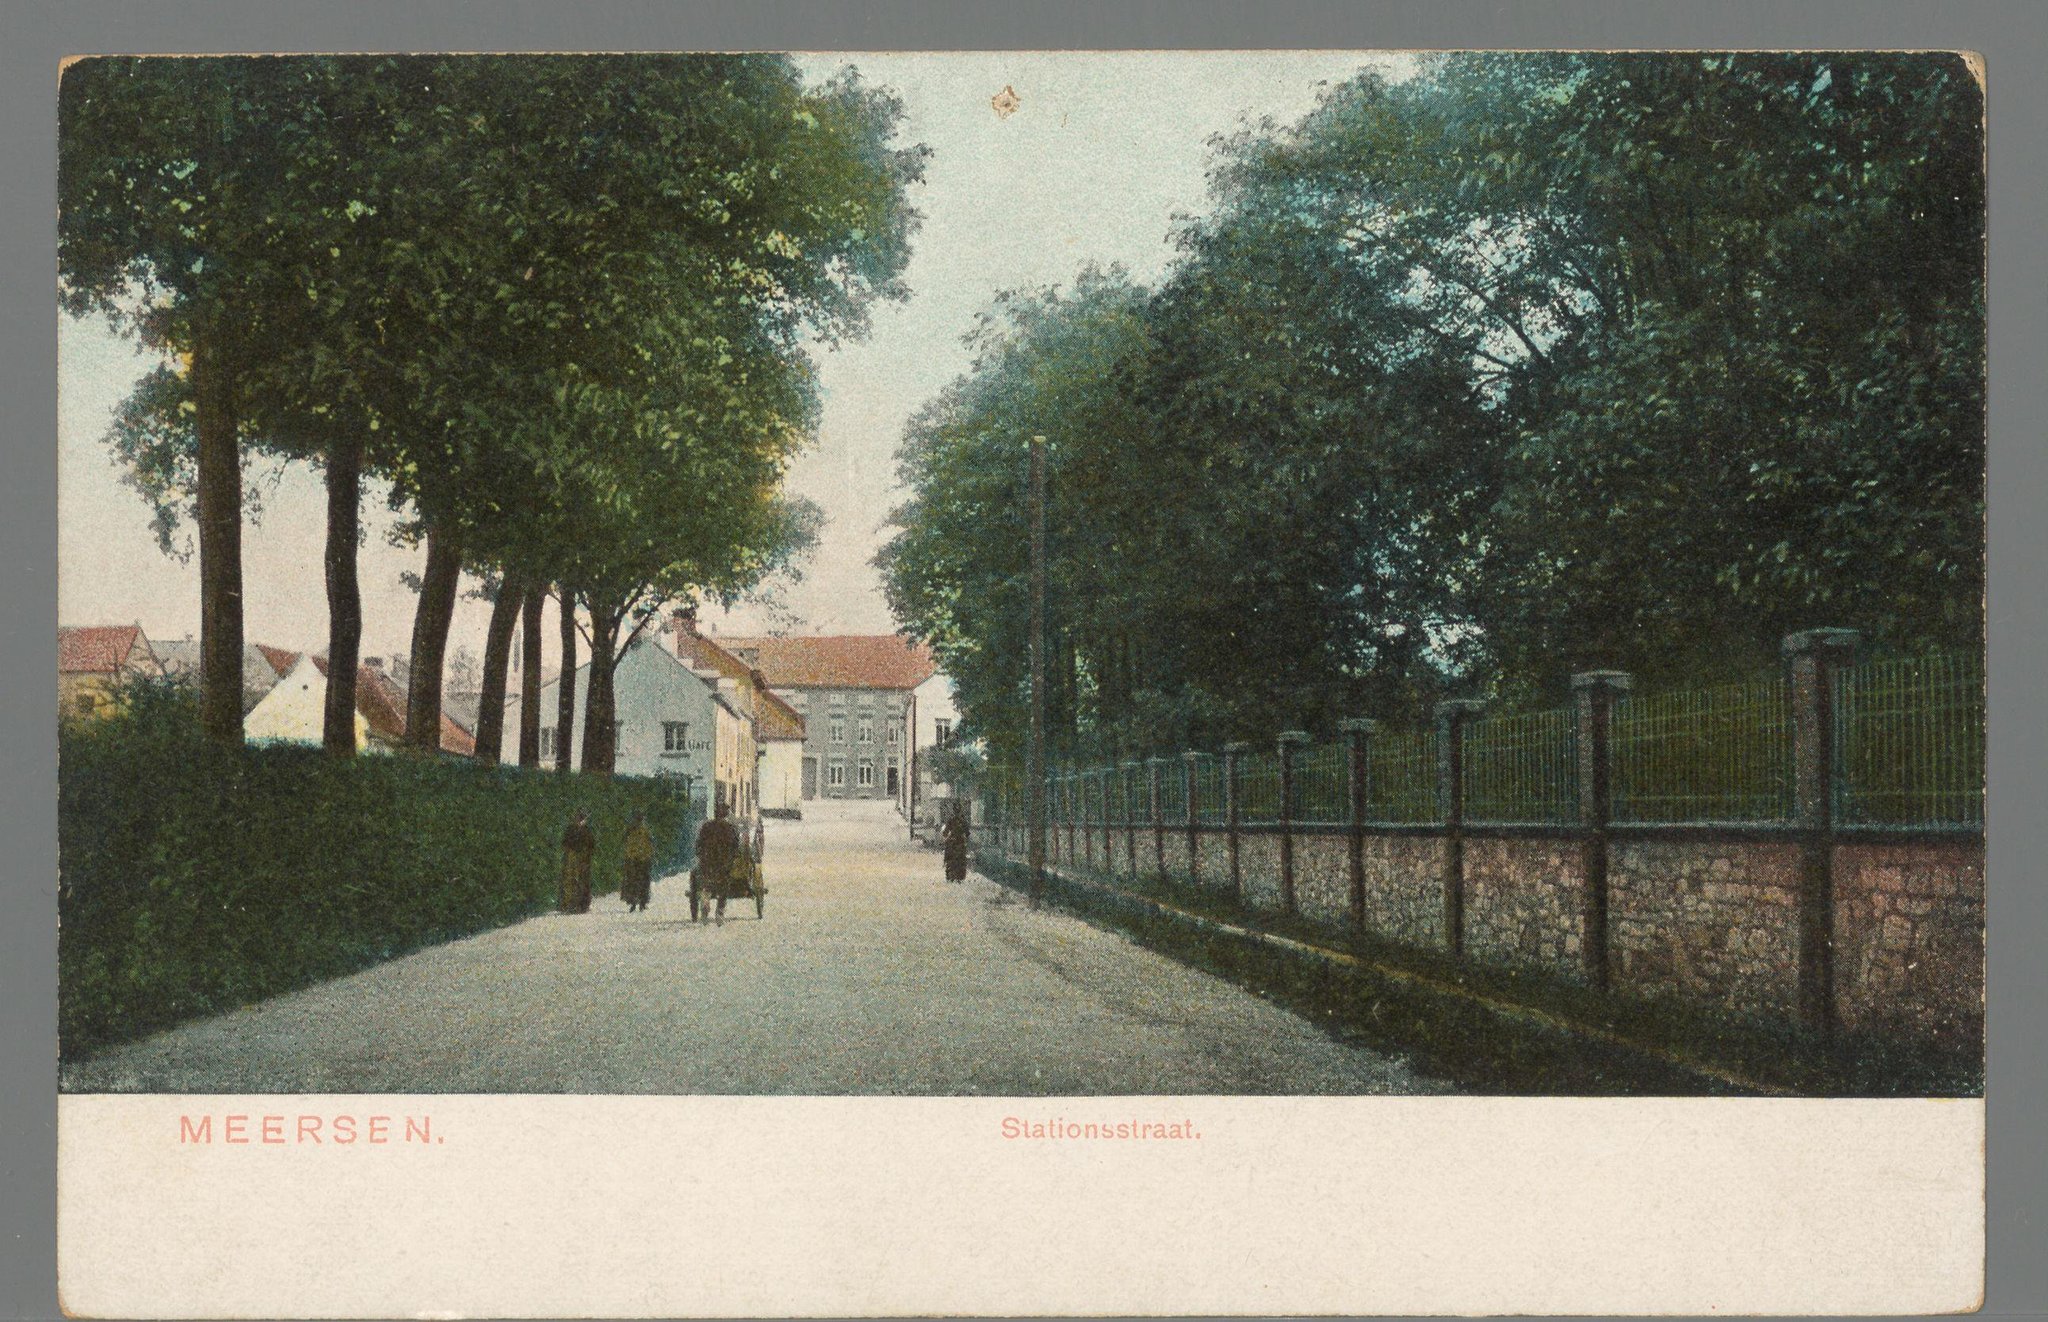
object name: ansichtkaart, prentbriefkaart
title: Meersen. Stationsstraat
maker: Anonymous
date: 1905-1906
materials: cardboard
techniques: lithograph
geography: leipzig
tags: street